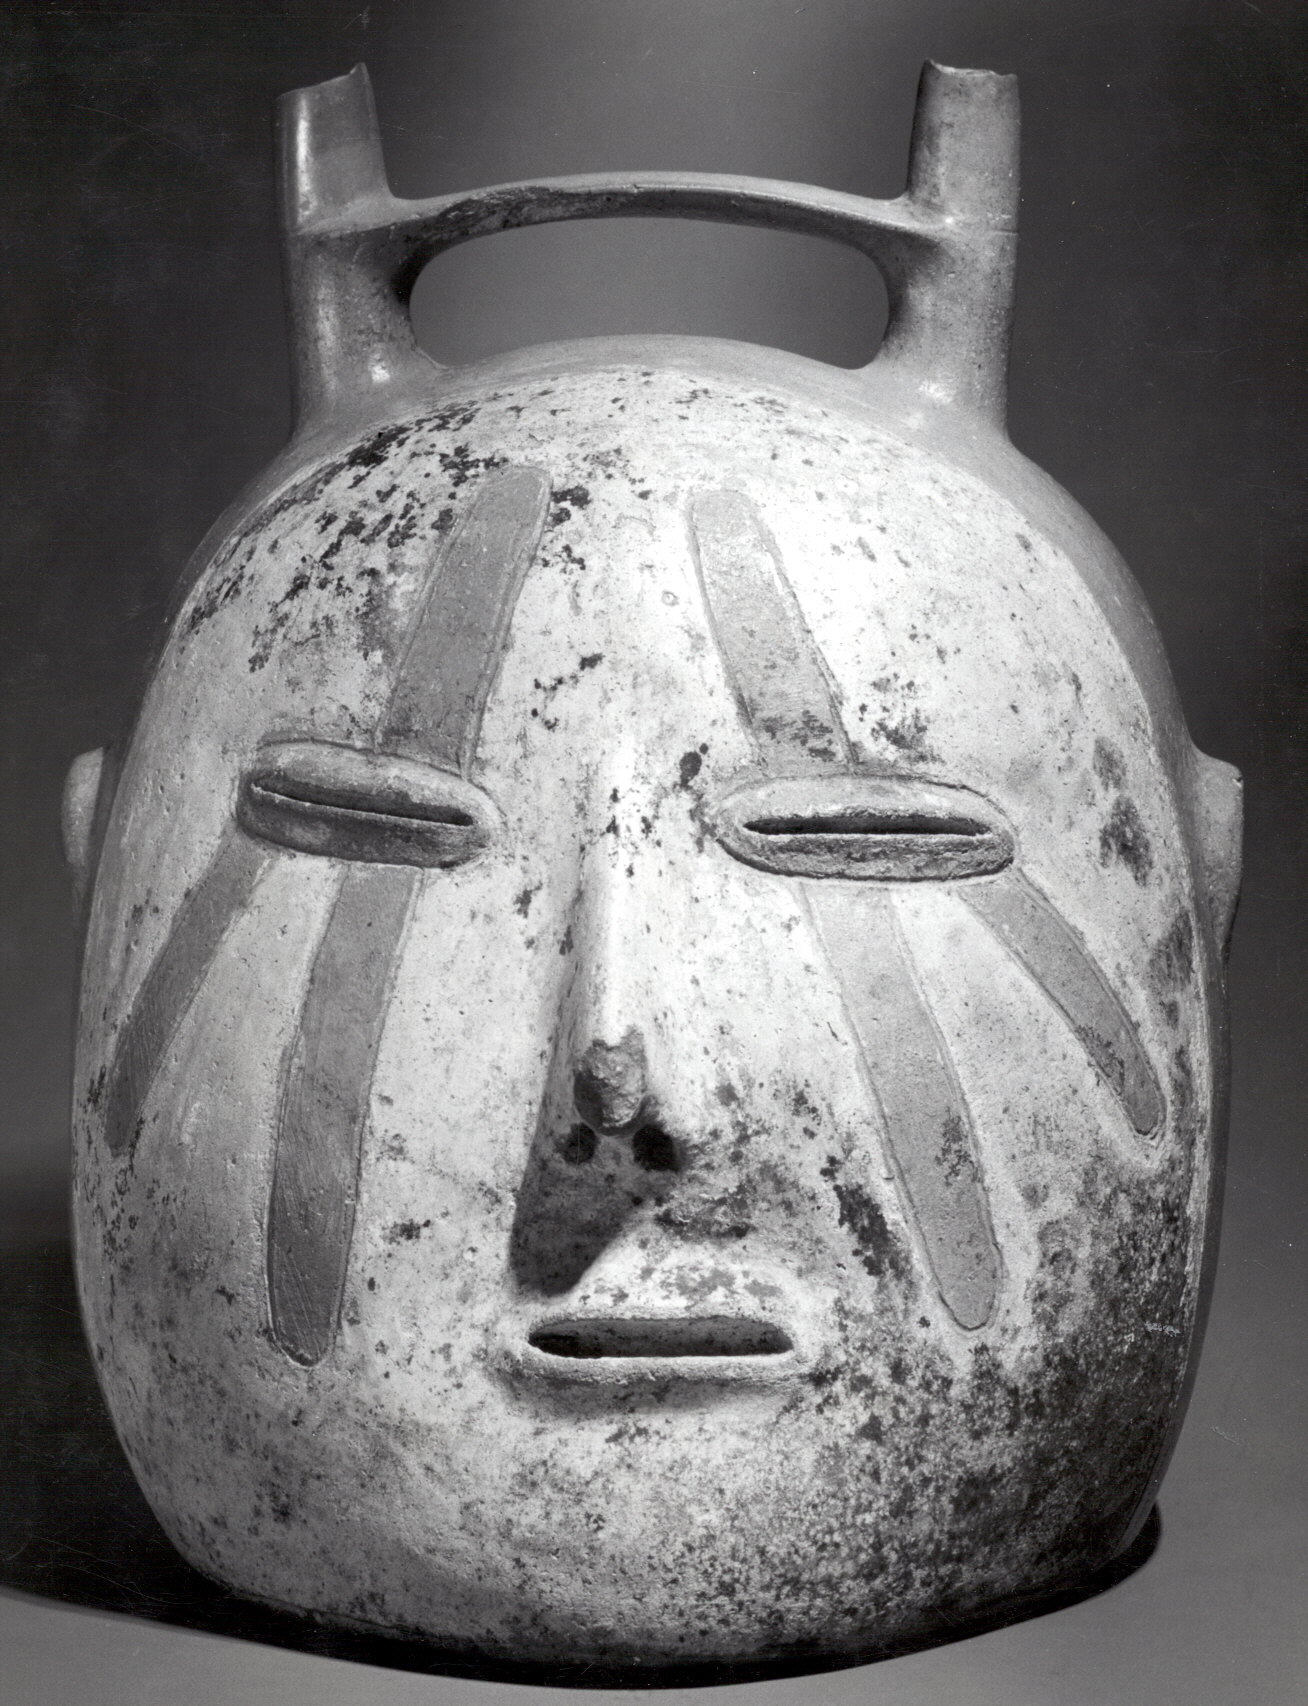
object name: bottle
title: Bottle, Trophy-Head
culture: topará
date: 200 BCE-100 CE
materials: ceramic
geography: peru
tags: heads